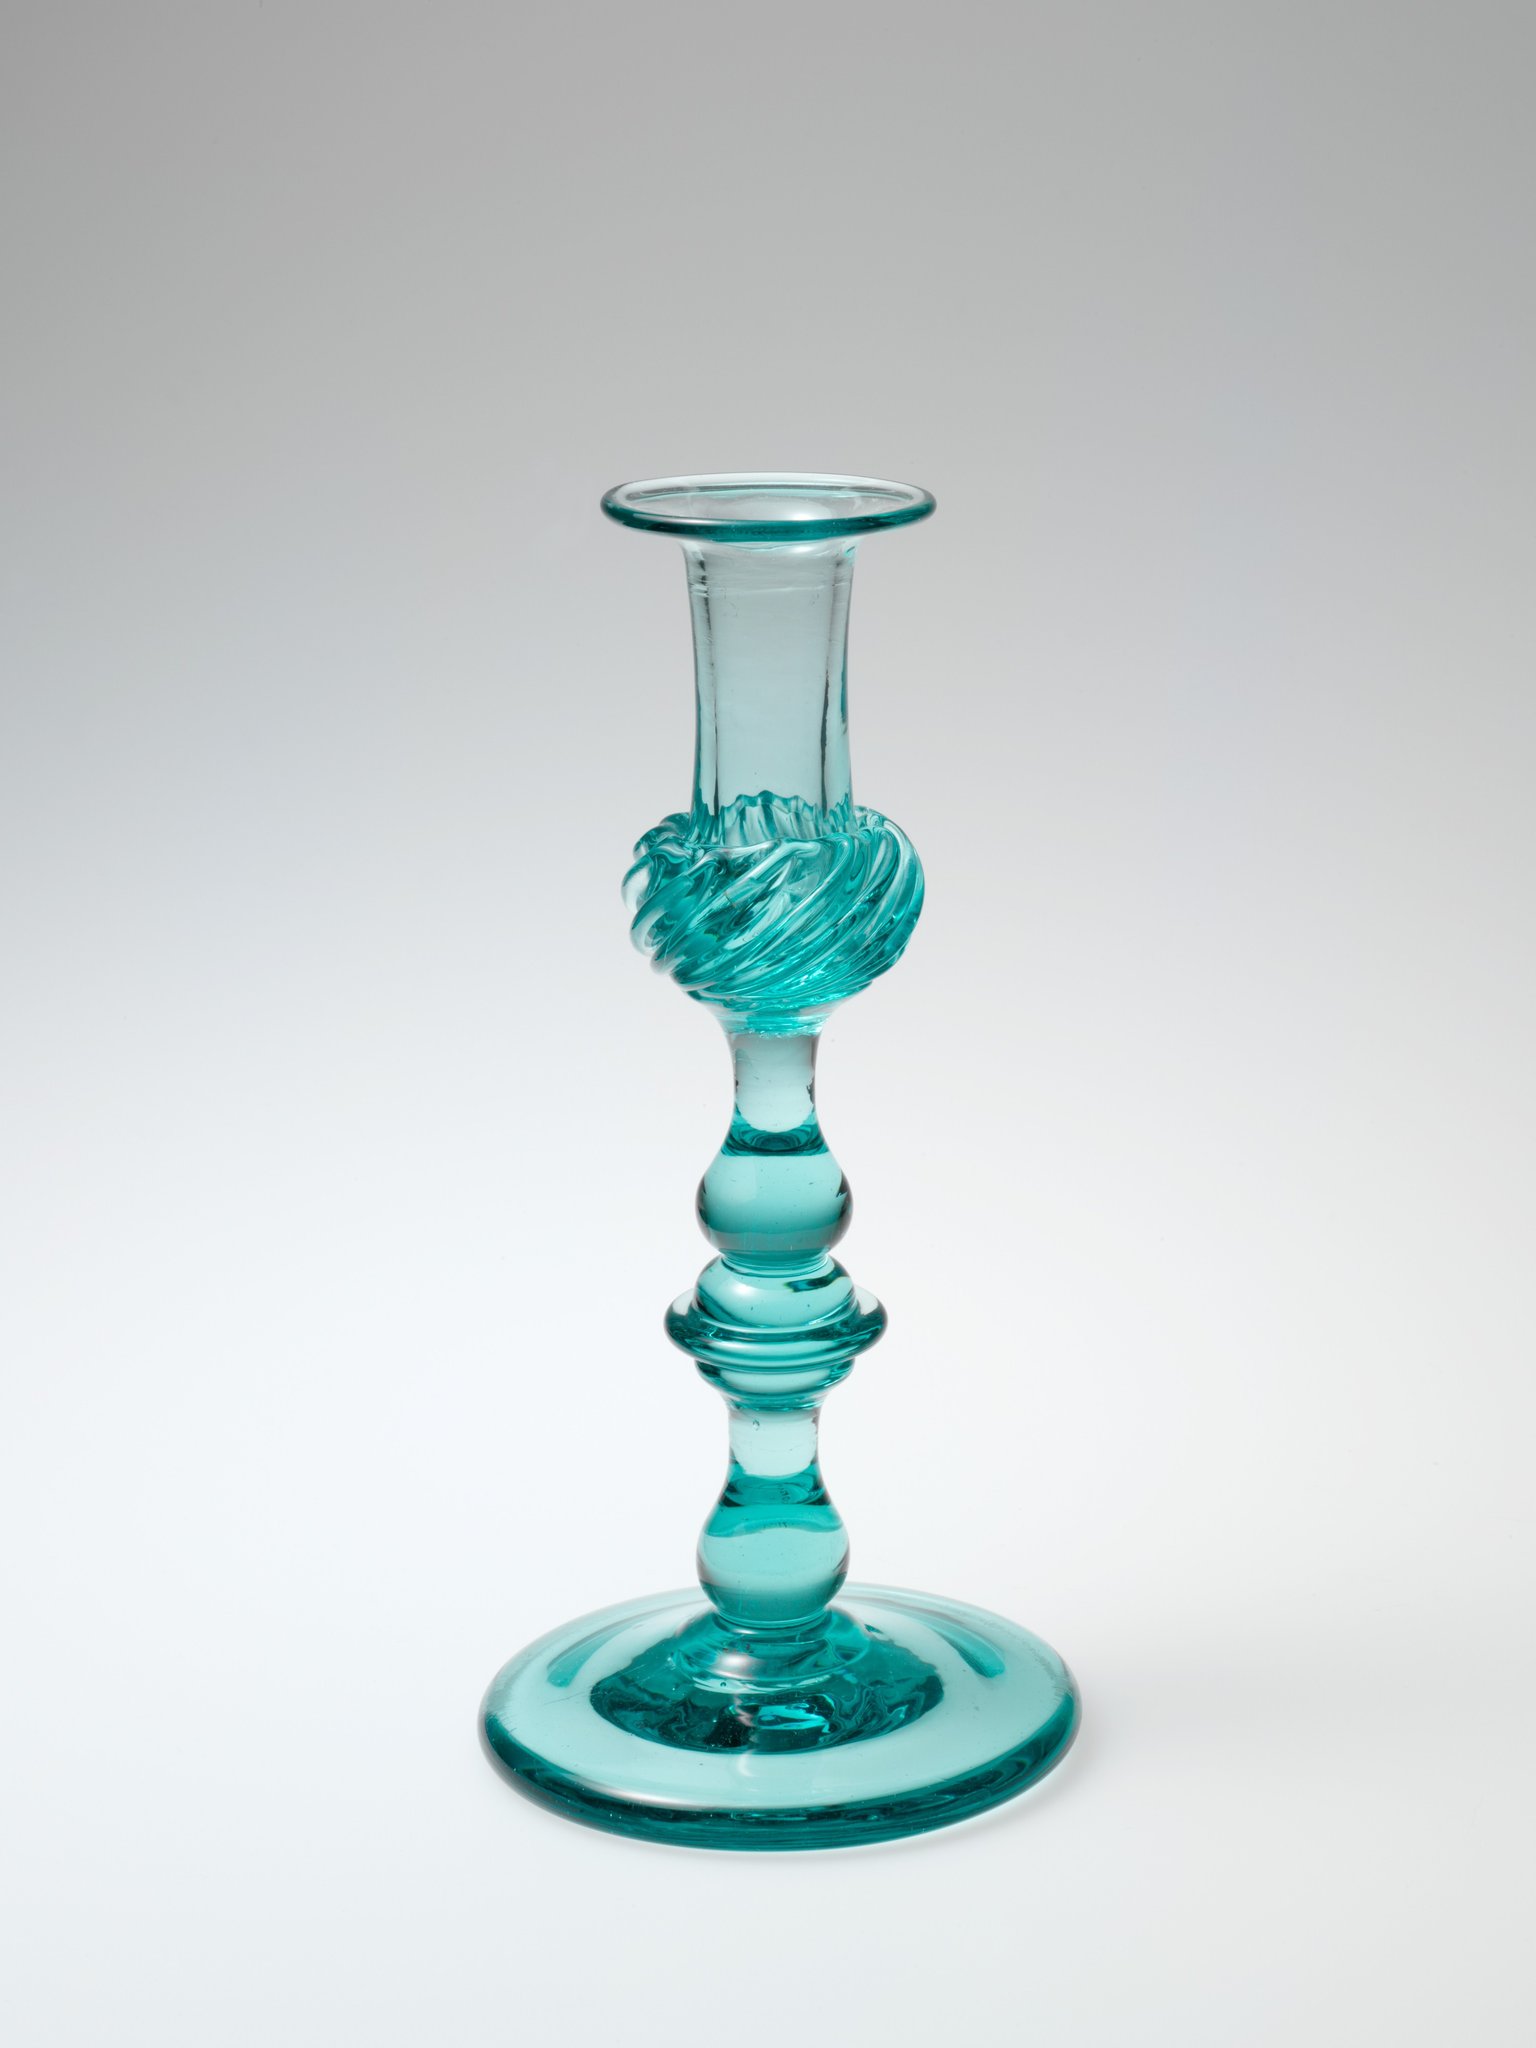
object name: candlestick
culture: american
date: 1830-1855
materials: glass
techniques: glassblowing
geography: united states